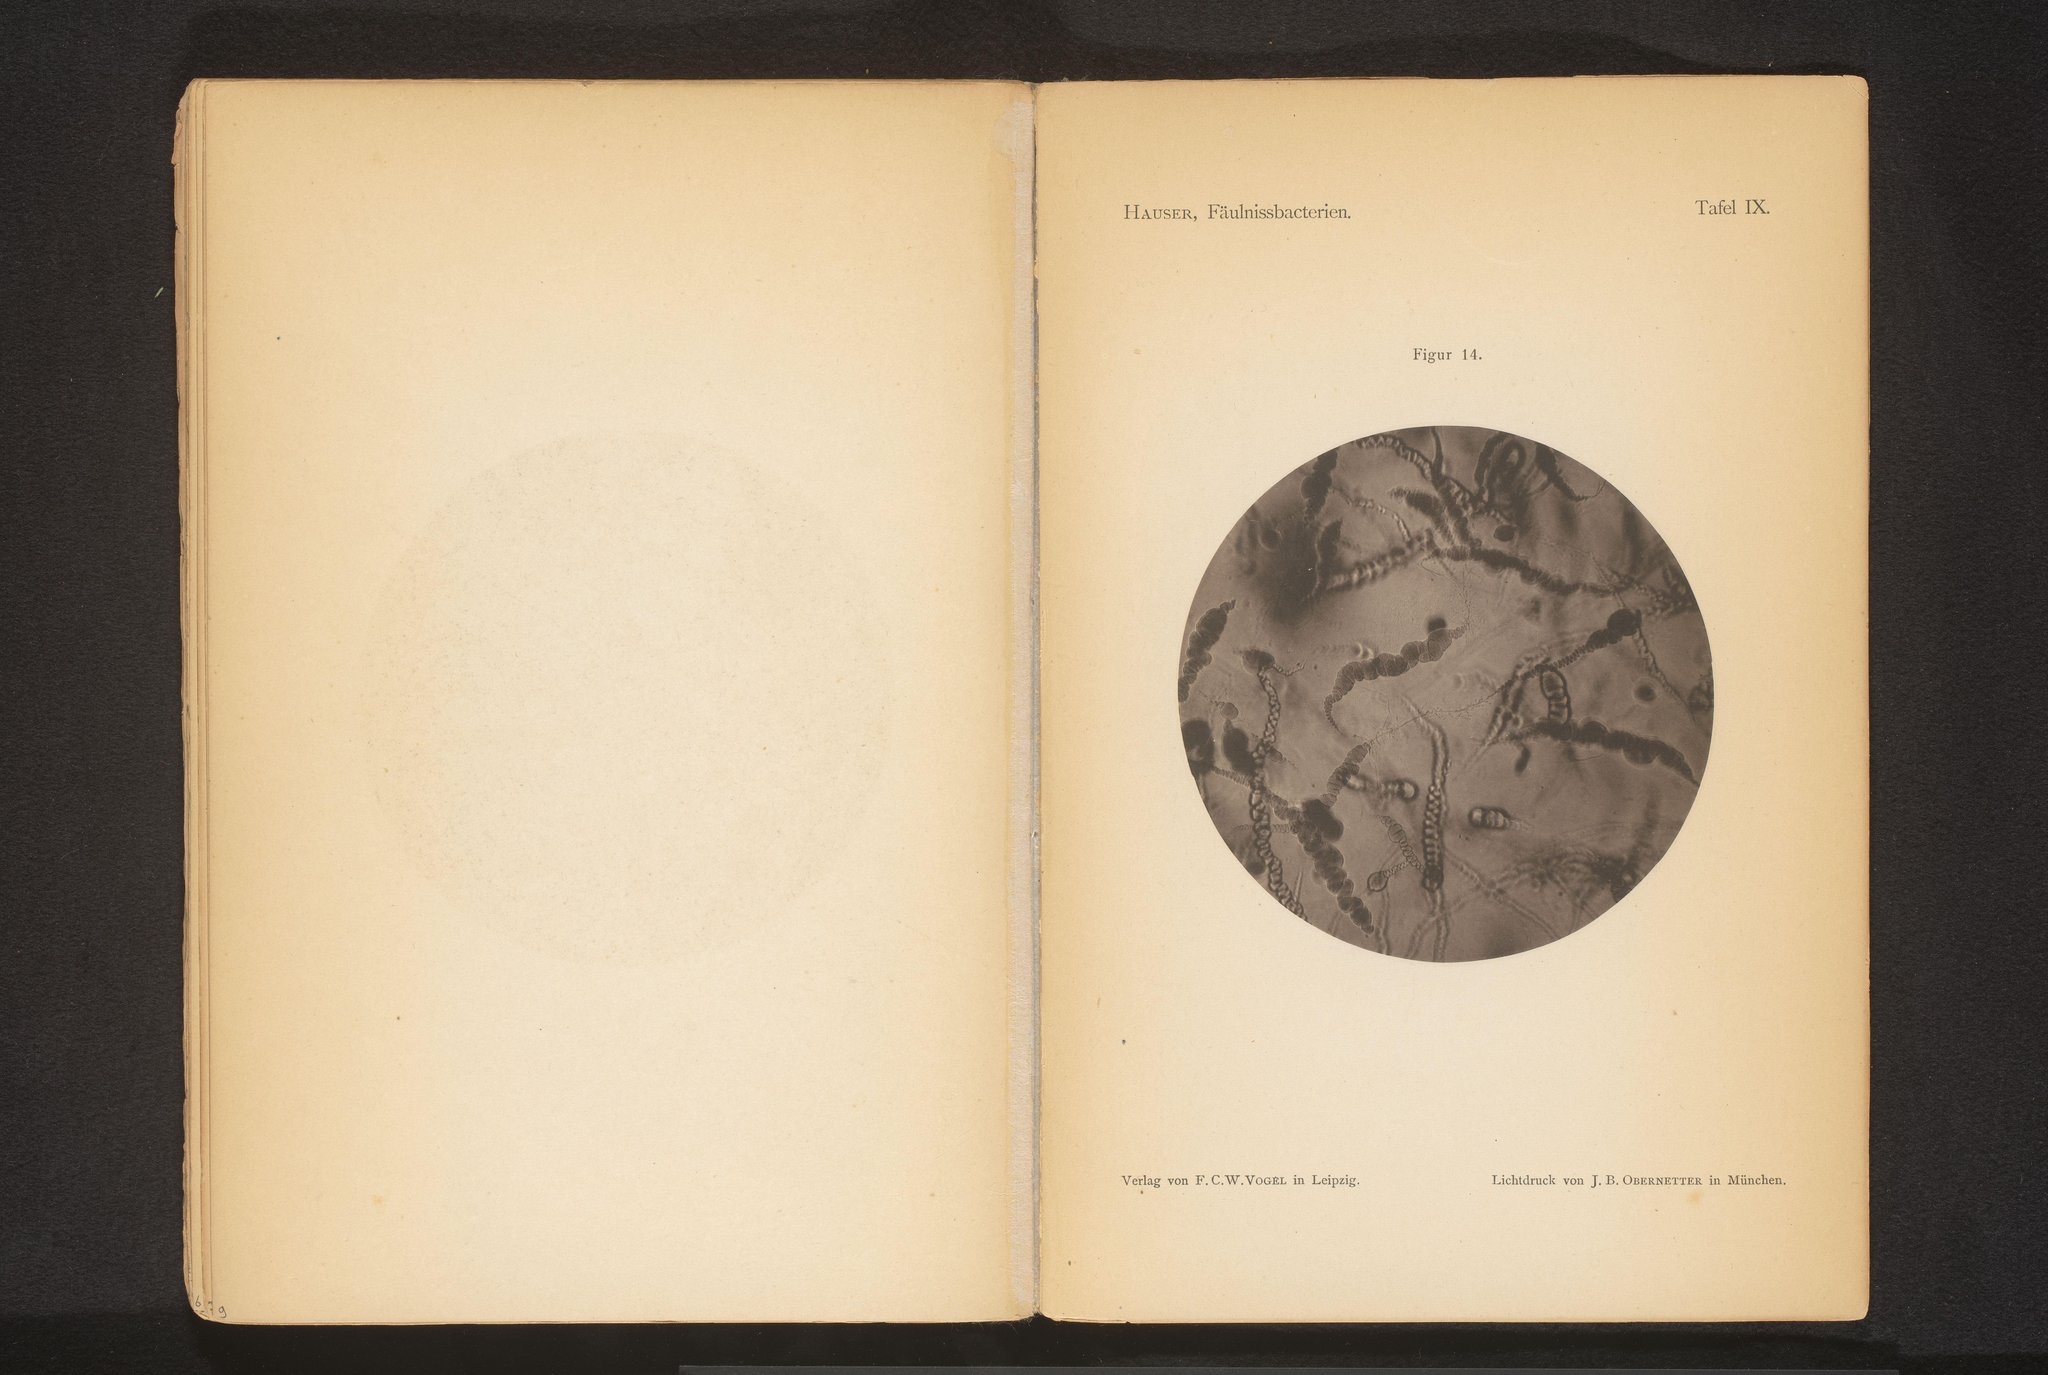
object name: page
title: Microscoopopname van bederfbacteriën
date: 1875-1885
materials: paper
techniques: photograph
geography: leipzig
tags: unicellular animals, bacteria, bacilli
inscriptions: number: ‘Tafel IX. Figur 14.’